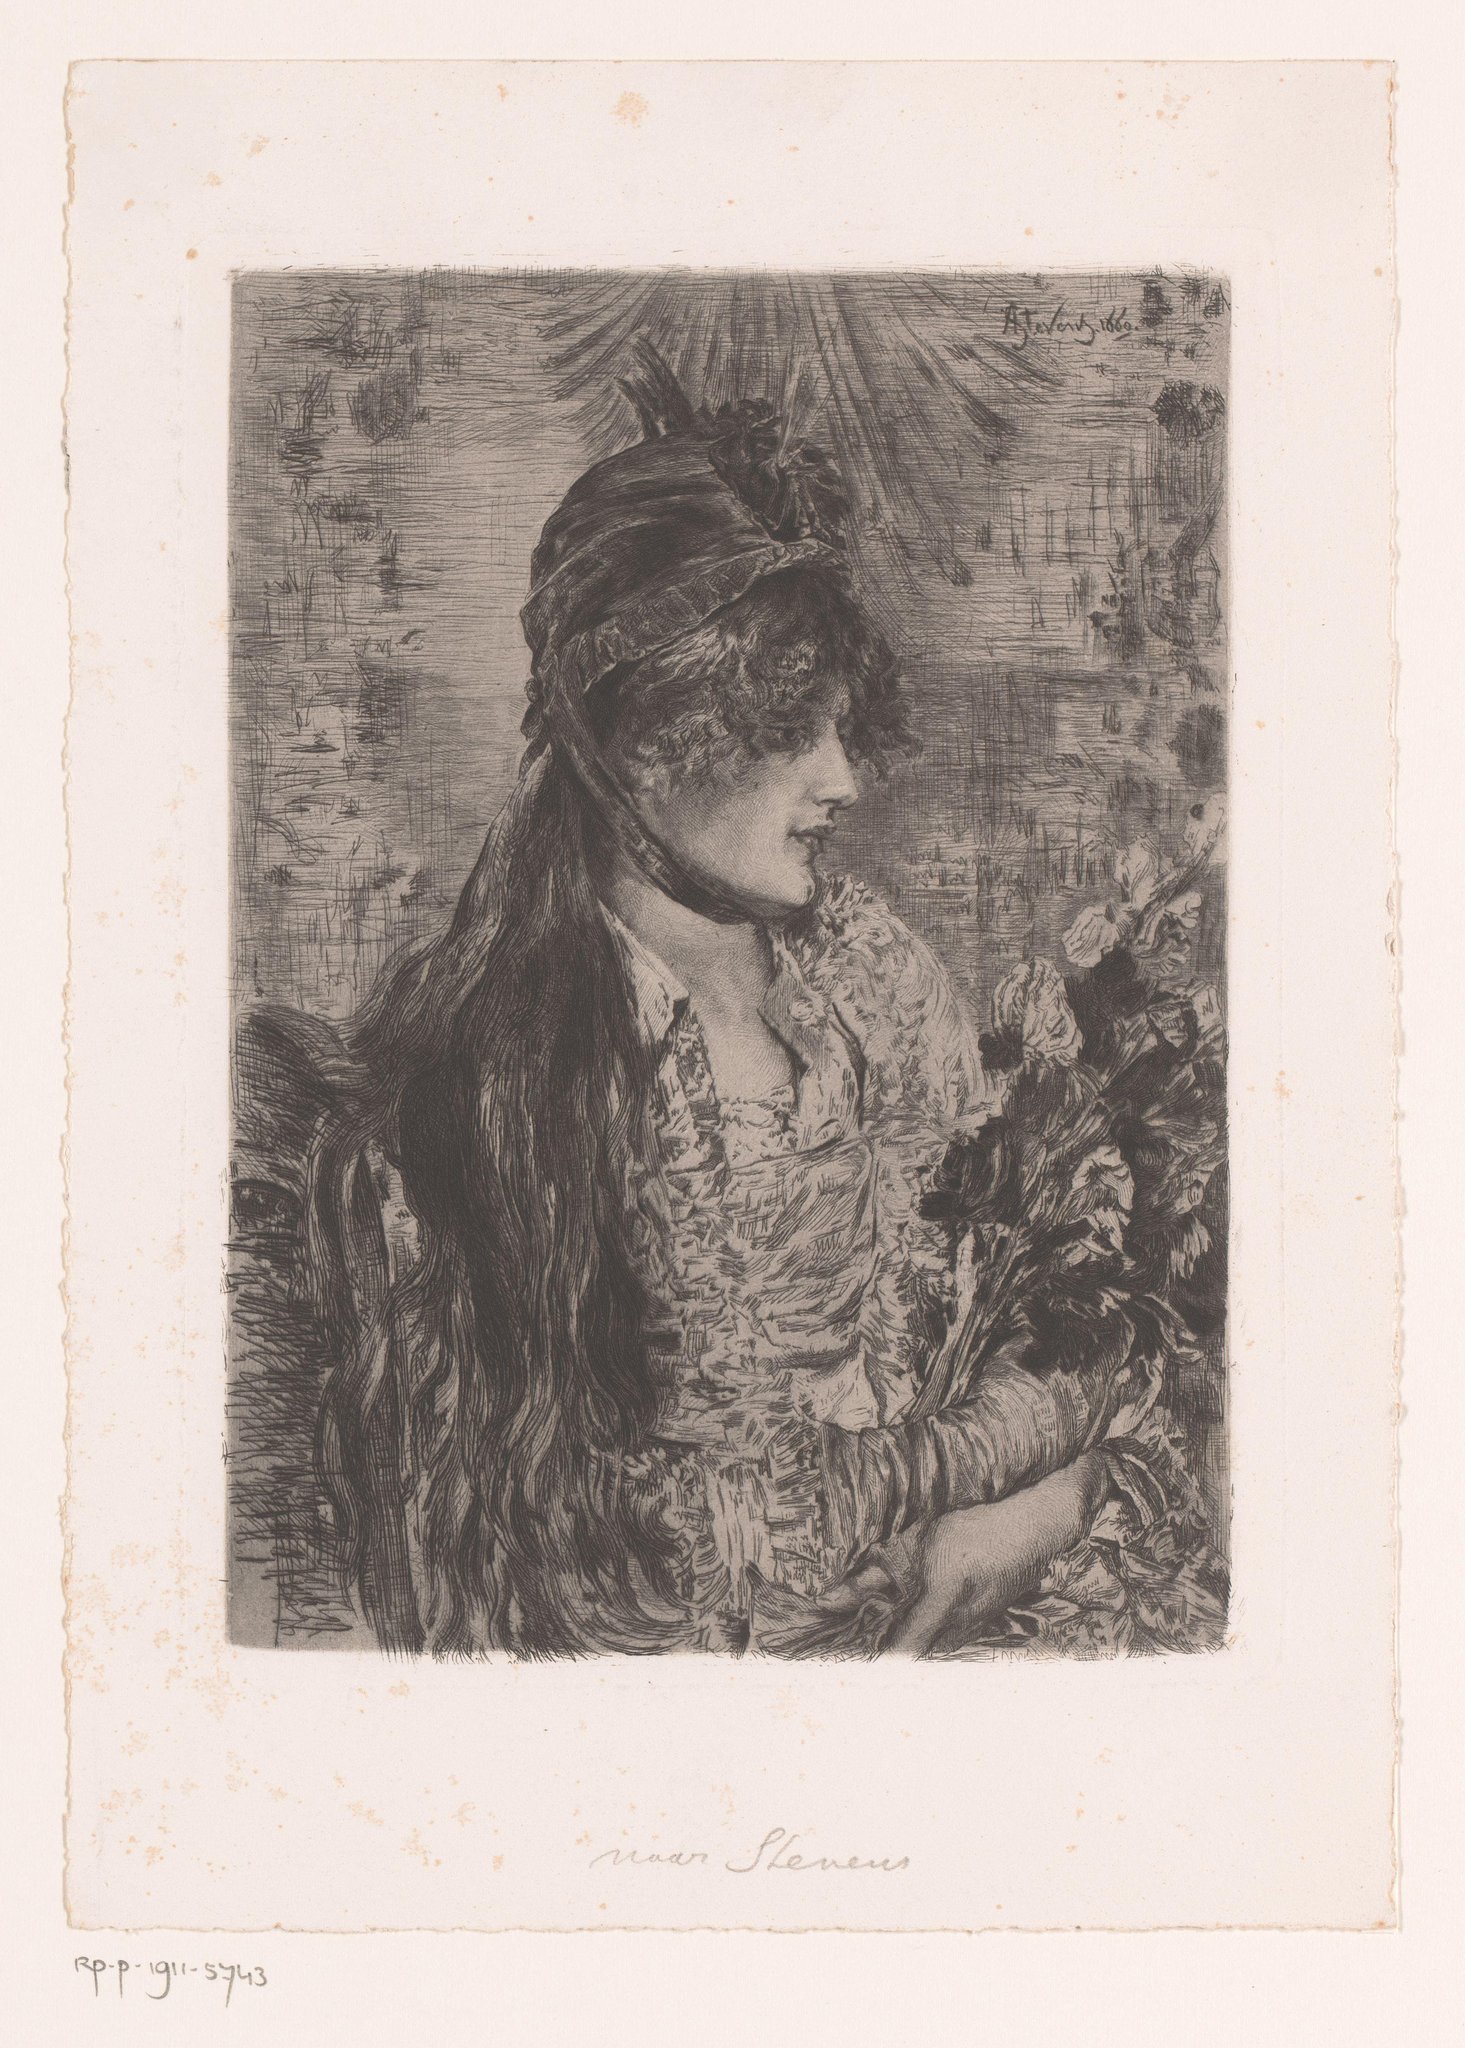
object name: print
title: Portret van een onbekende jonge vrouw met een boeket in haar armen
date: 1864-1911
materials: paper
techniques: drypoint, etching, intaglio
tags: adolescent, young woman, maiden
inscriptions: collector's mark: Lugt 2228